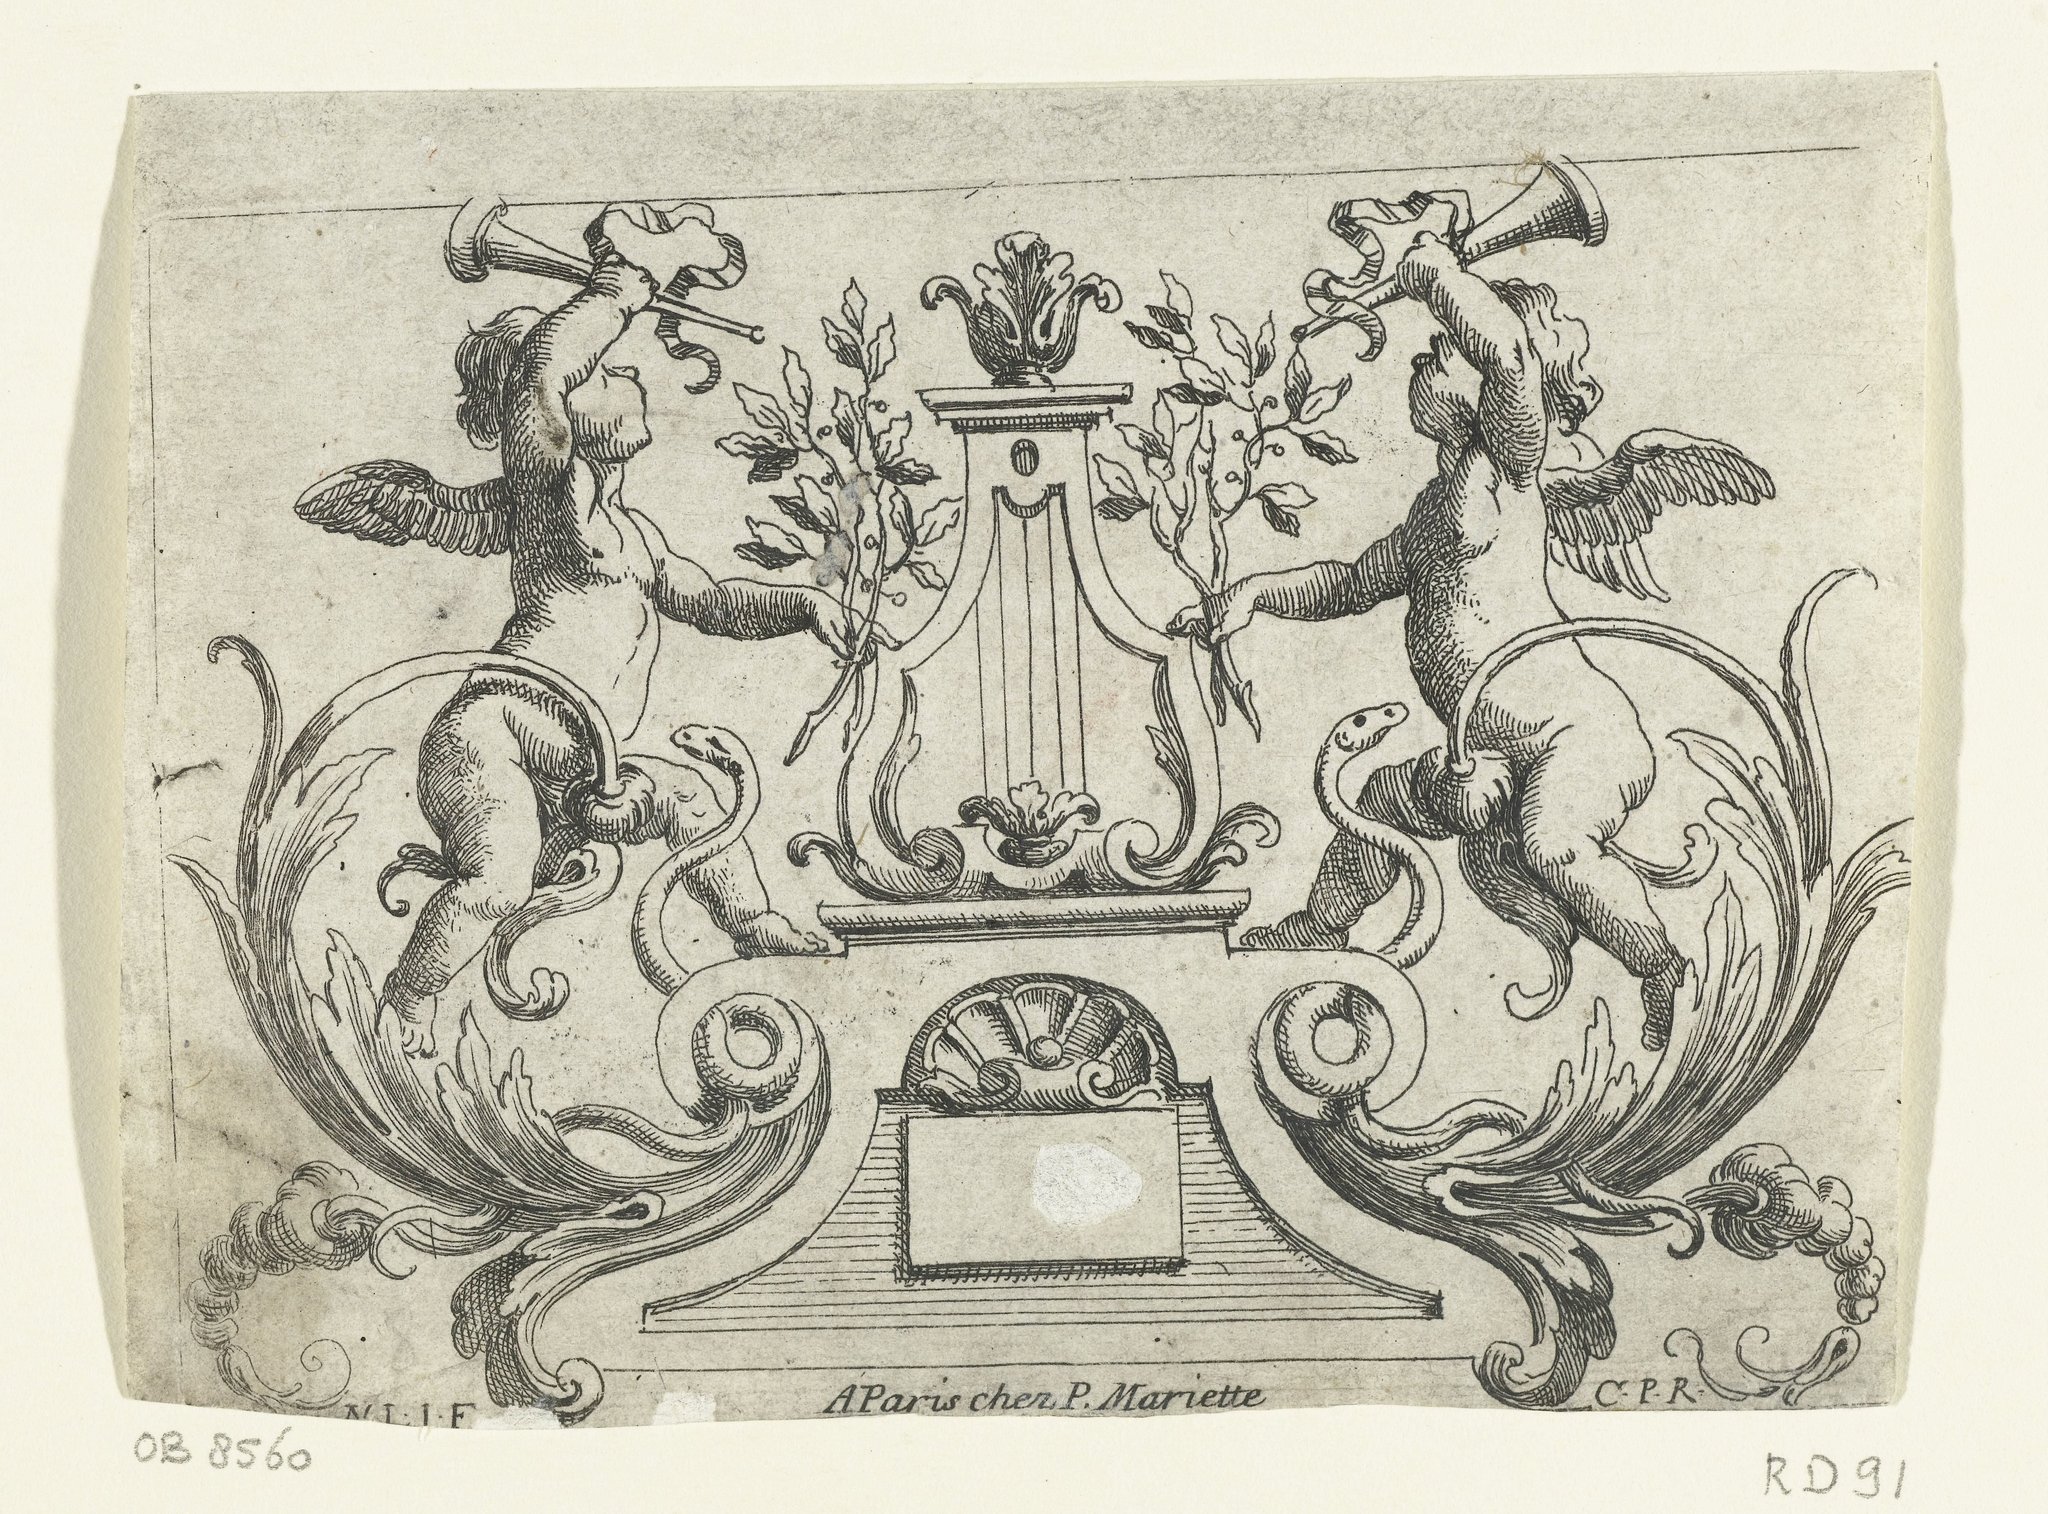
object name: ornament print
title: Twee cherubijnen naast lier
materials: paper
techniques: etching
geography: france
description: Beide cherubijnen houden een trompet een een lauriertak vast. Blad 8 uit serie van 12, eerste editie.